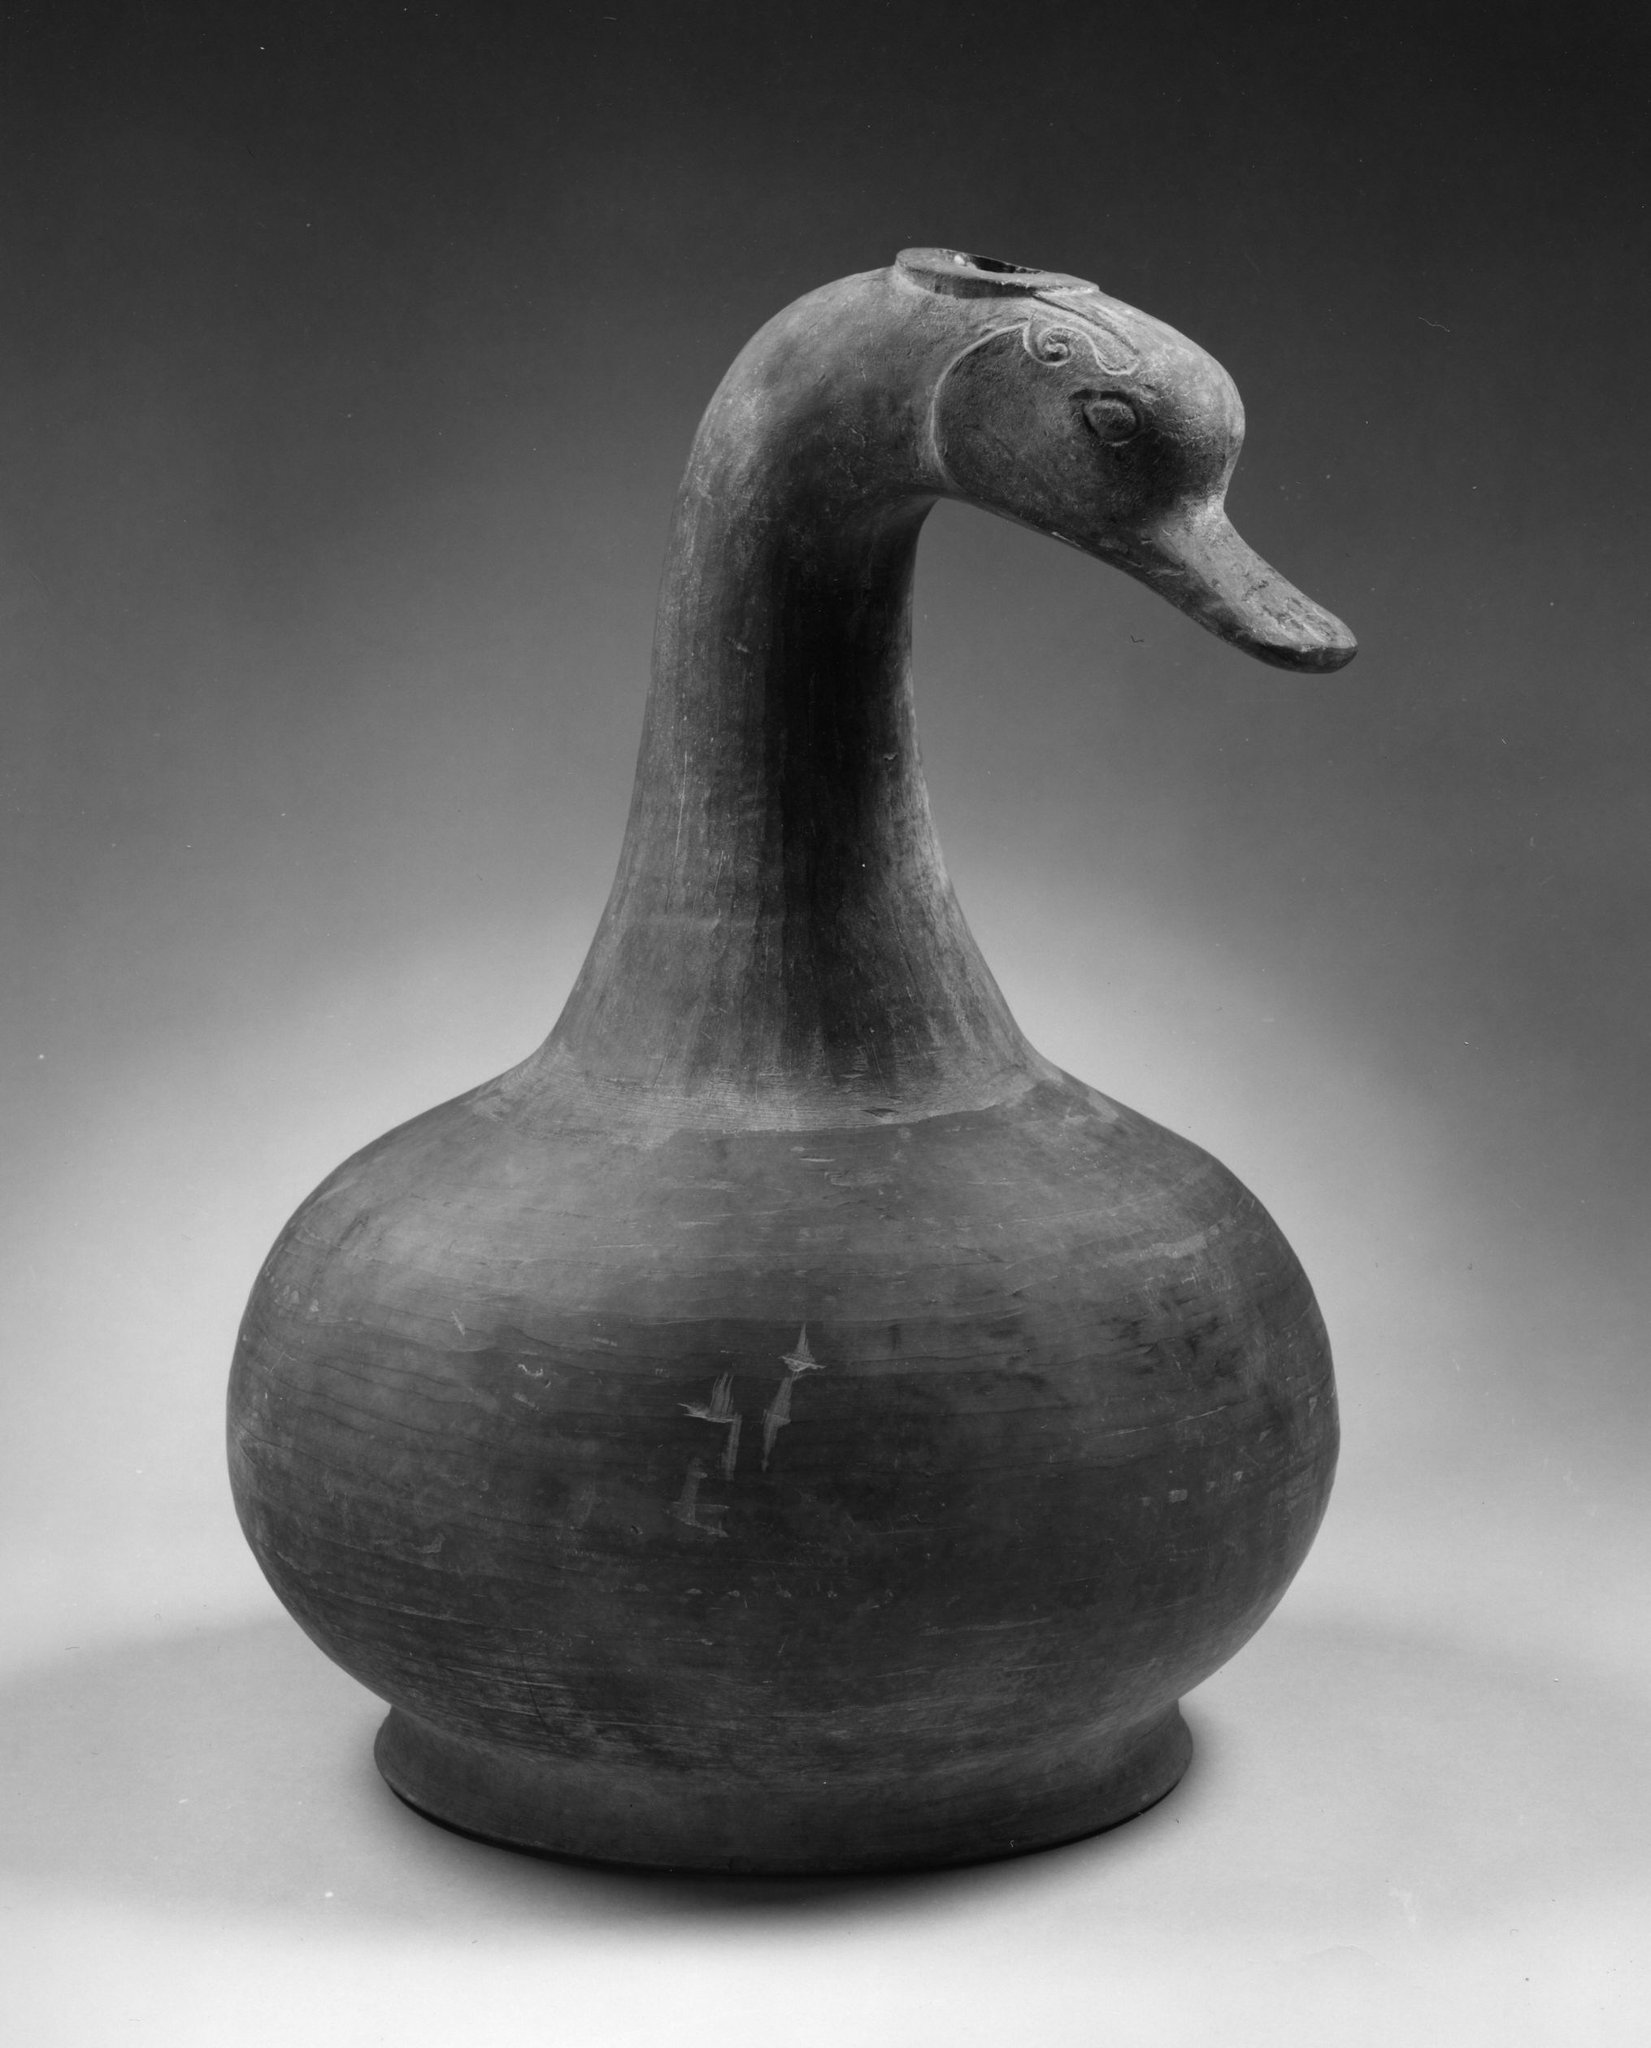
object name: vessel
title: Goose-headed Vessel (Zun)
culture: chinese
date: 206 BCE-220 CE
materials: earthenware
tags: geese